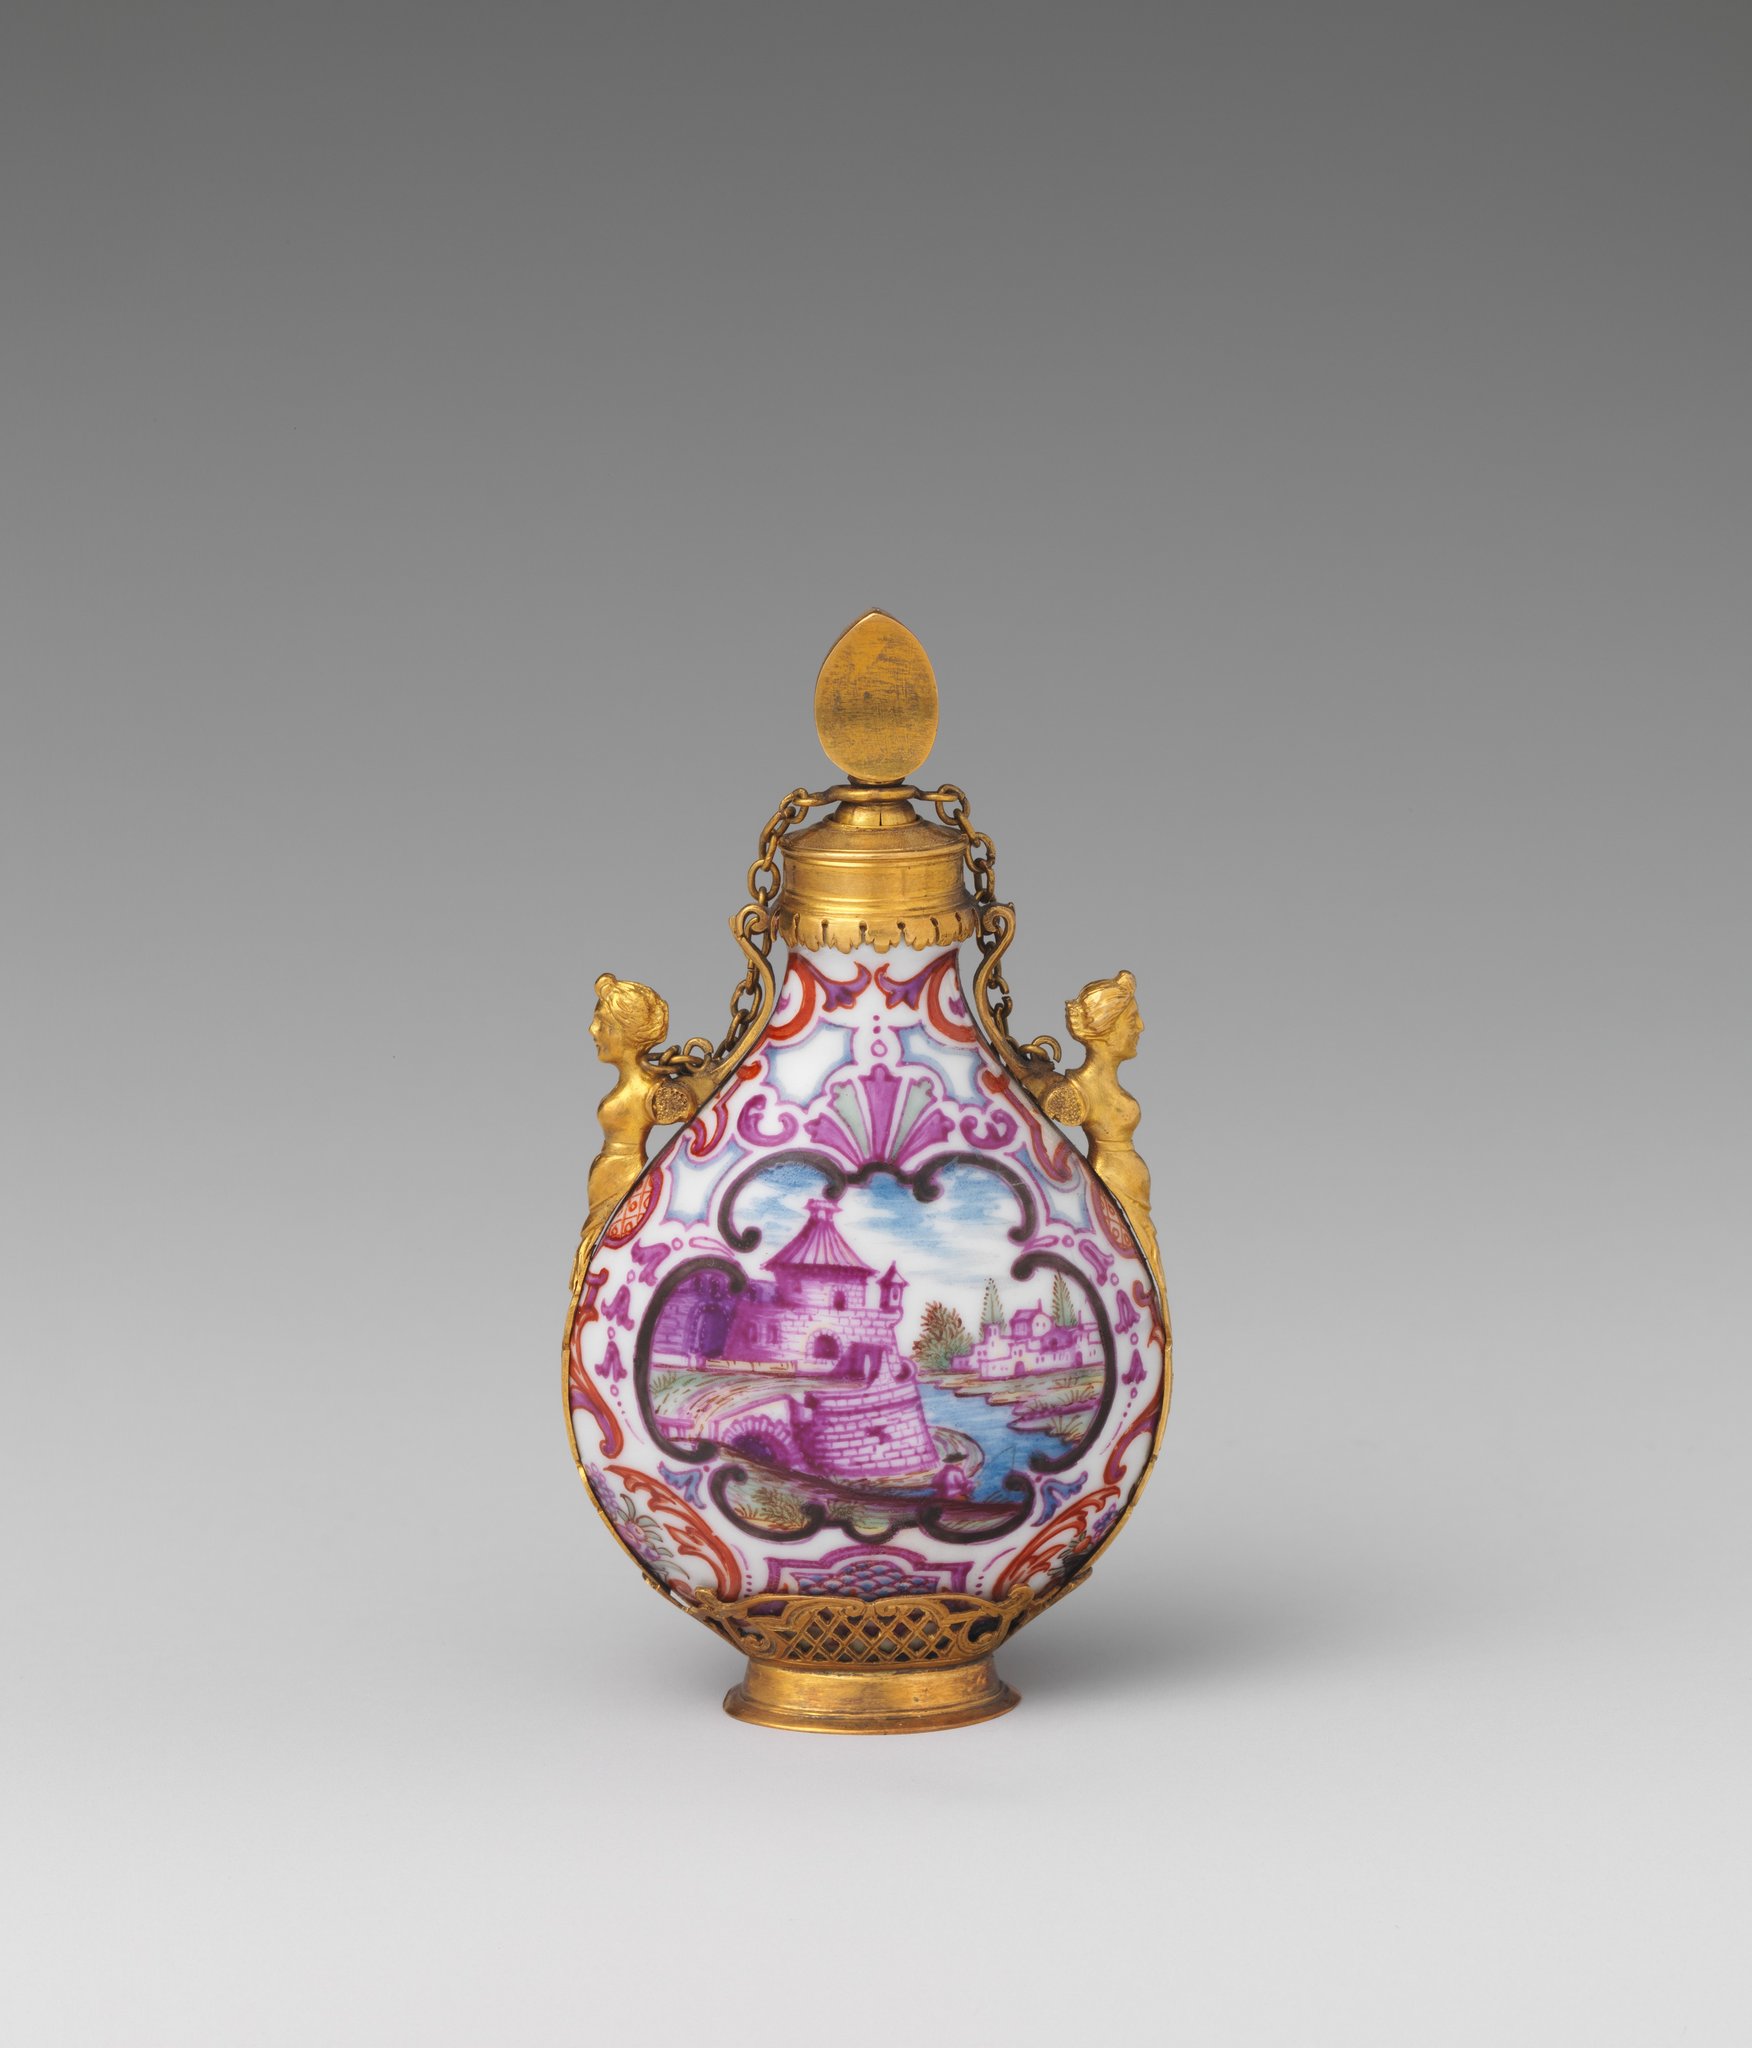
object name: scent bottle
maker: vienna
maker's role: manufactory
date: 1730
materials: gold, hard paste porcelain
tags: houses